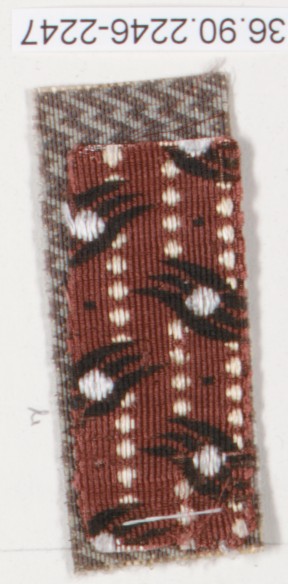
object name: piece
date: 1801-1900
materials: silk